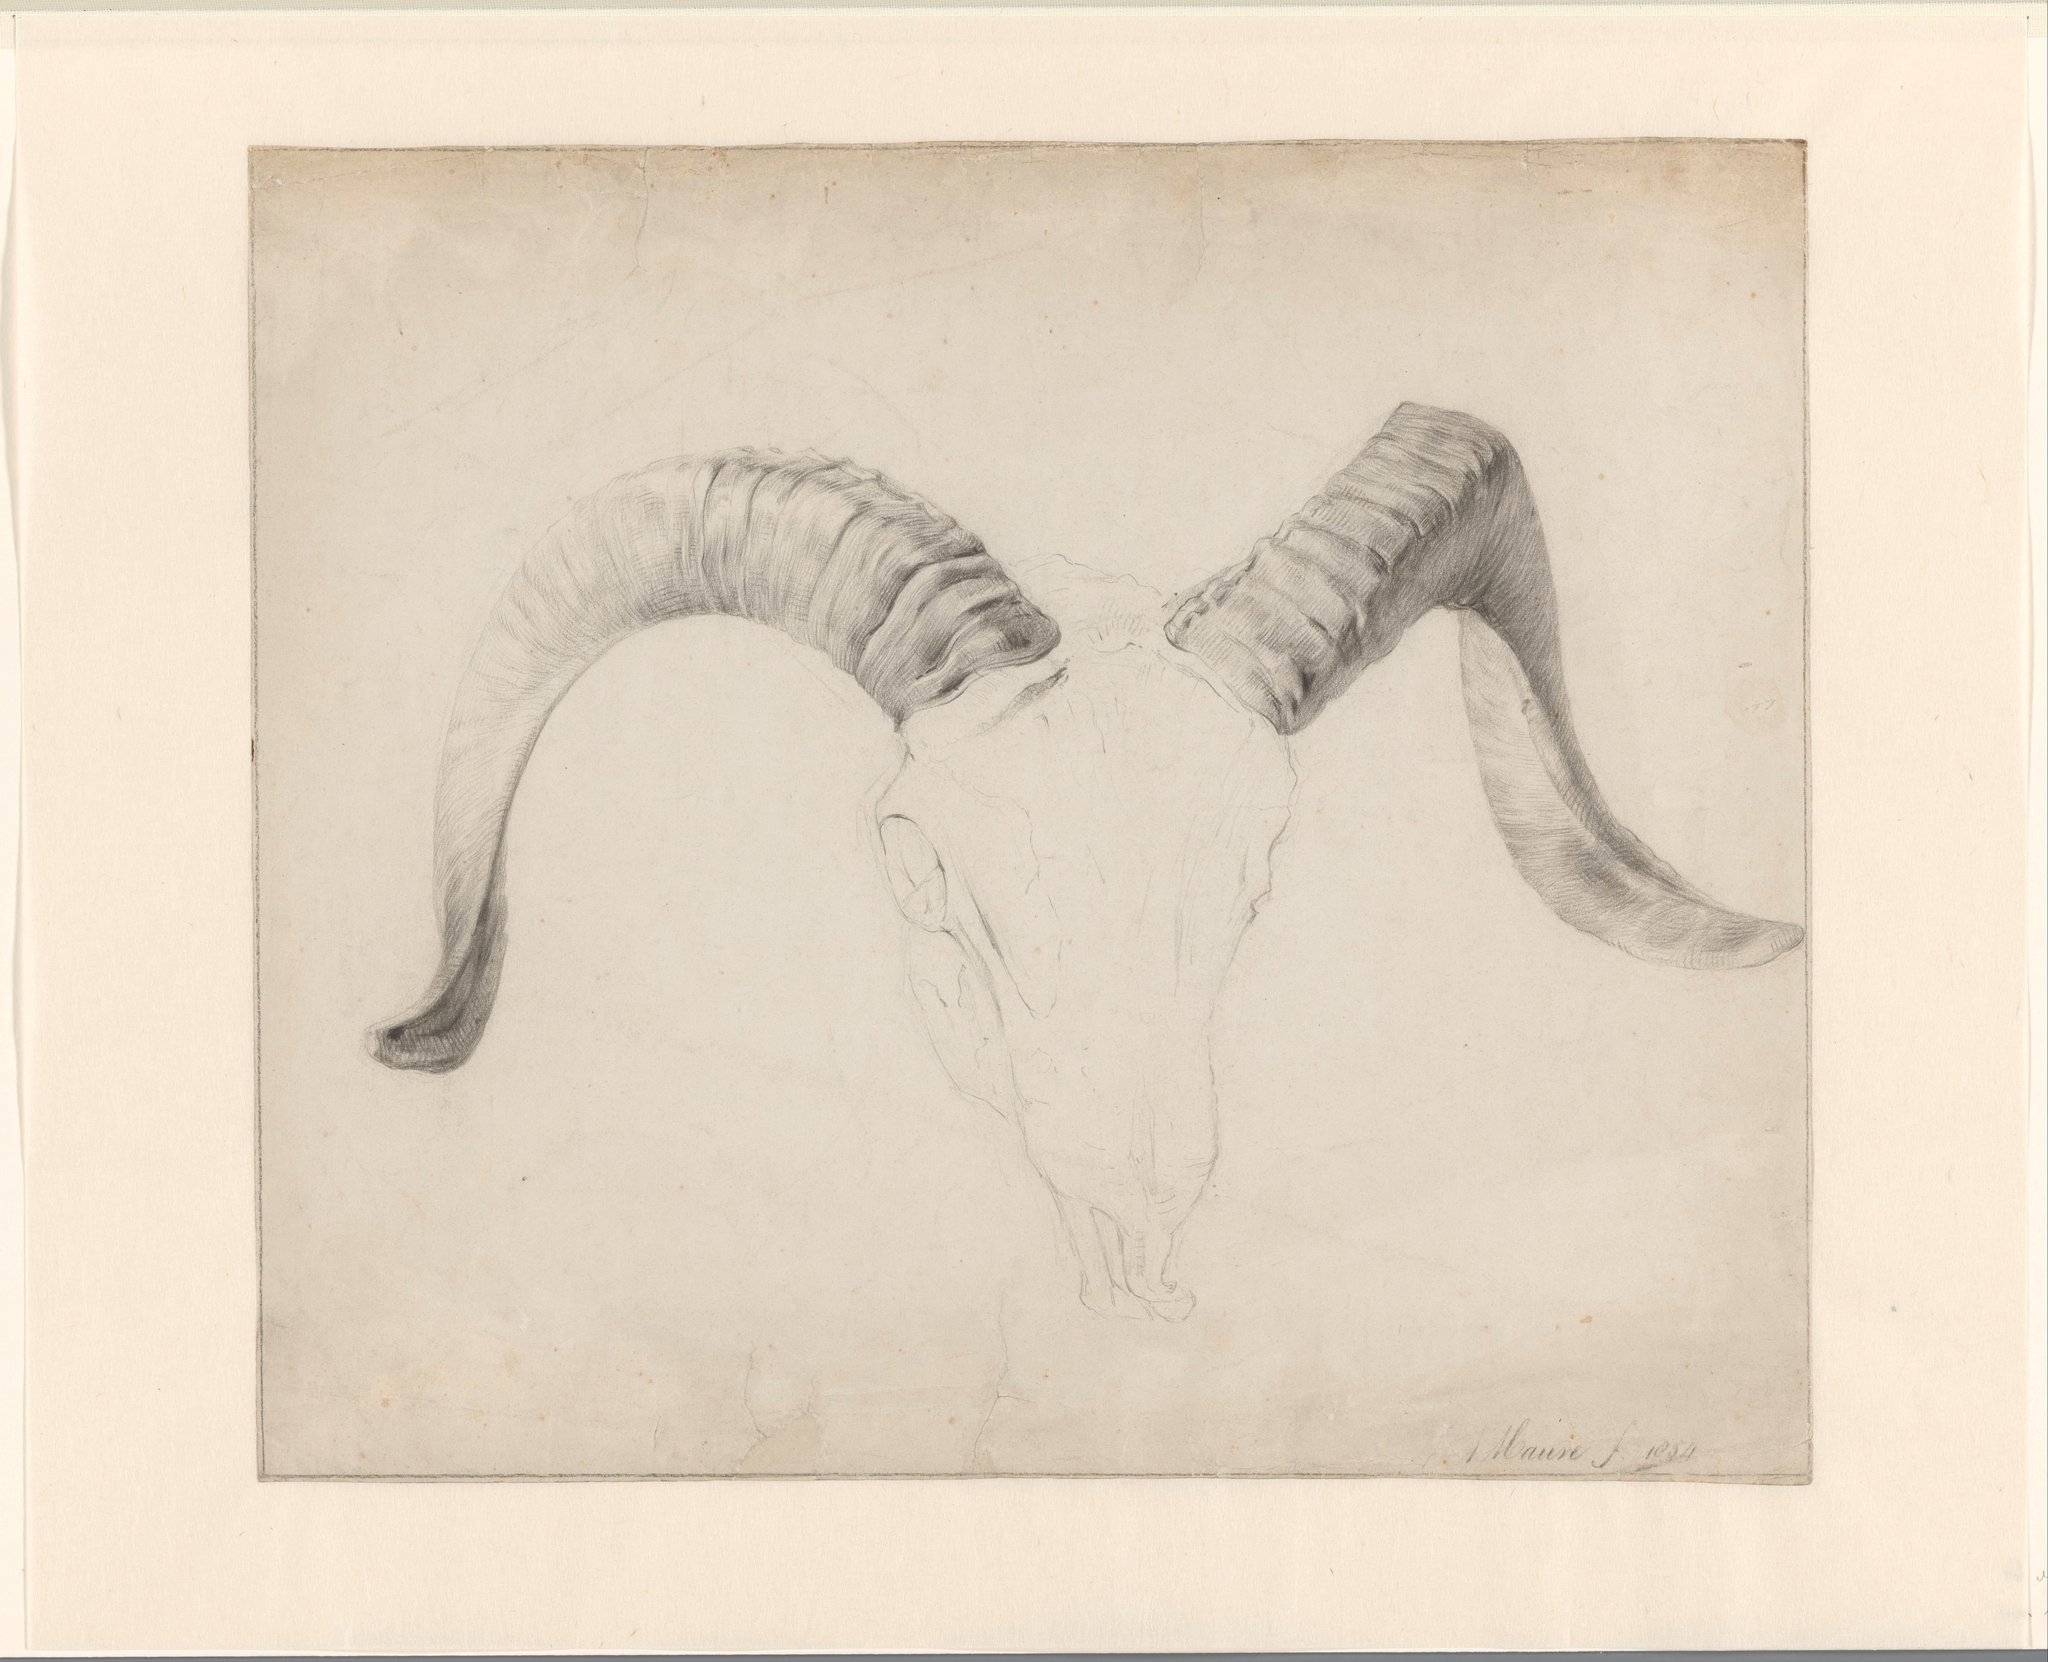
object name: drawing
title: Schedel van een bok, de horens uitgewerkt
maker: anton mauve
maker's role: draughtsman, painter, print maker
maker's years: 1838-1888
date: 1854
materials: chalk, paper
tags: goat (+ antlers; horn)